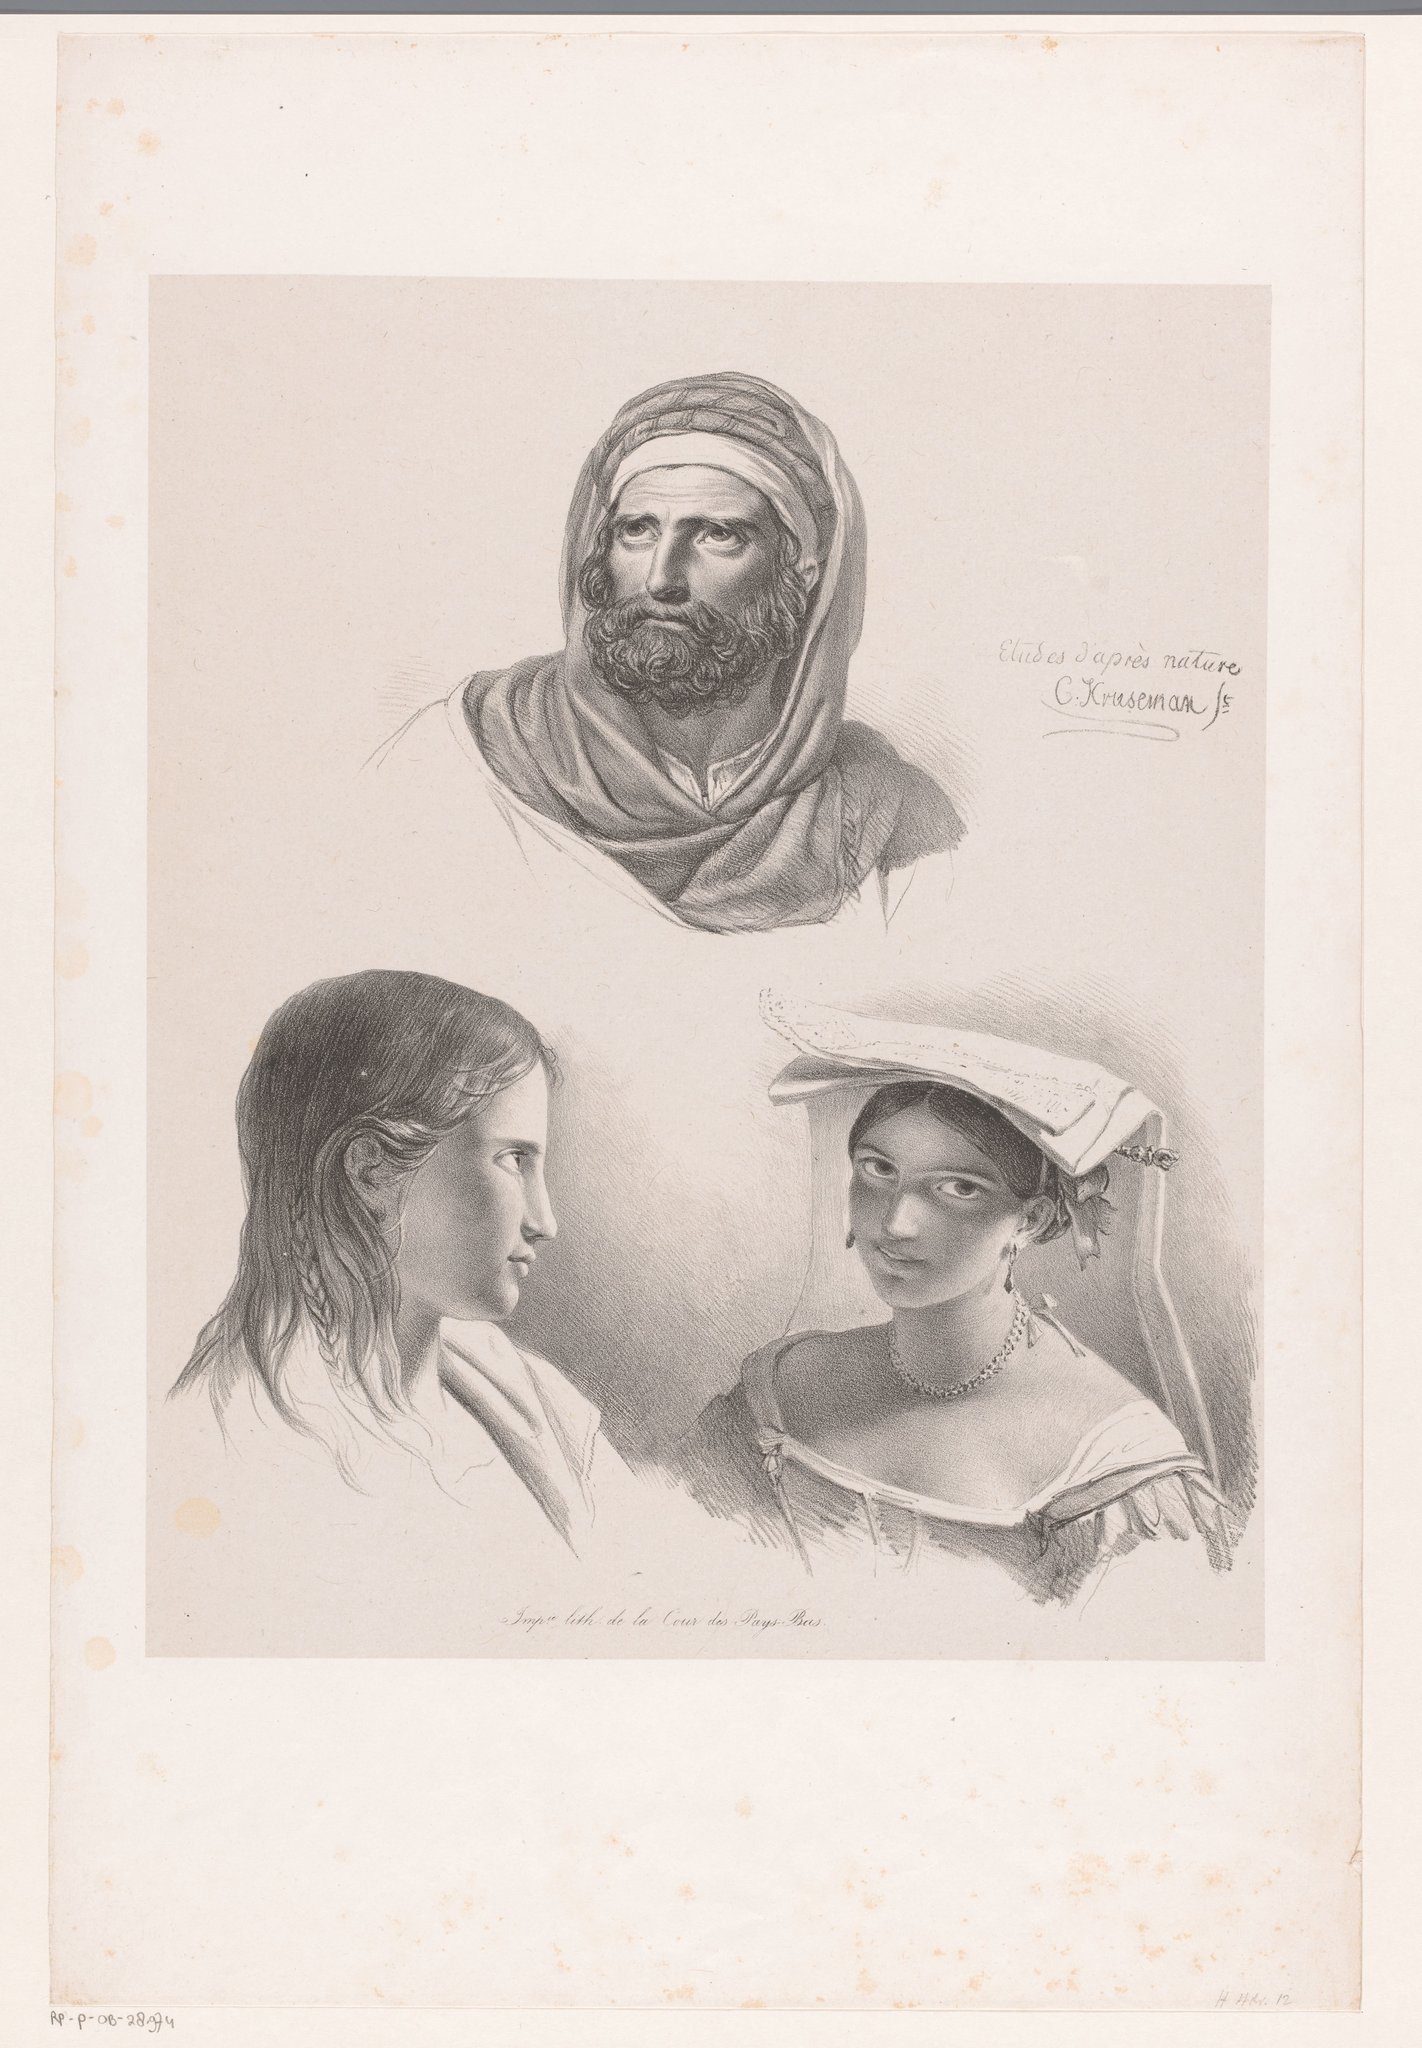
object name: print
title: Drie portretten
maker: cornelis kruseman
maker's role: draughtsman, painter, print maker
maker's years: 1797-1857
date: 1809-1857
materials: paper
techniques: lithograph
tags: historical persons (+ head (and shoulders) (portrait)), old man, europeans (with name) (+ costume)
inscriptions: collector's mark: Lugt 2228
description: Bovenin een oudere man met een baard, linksonder een meisje of jongen met lang haar en rechtsonder een vrouw in Italiaanse kleding.